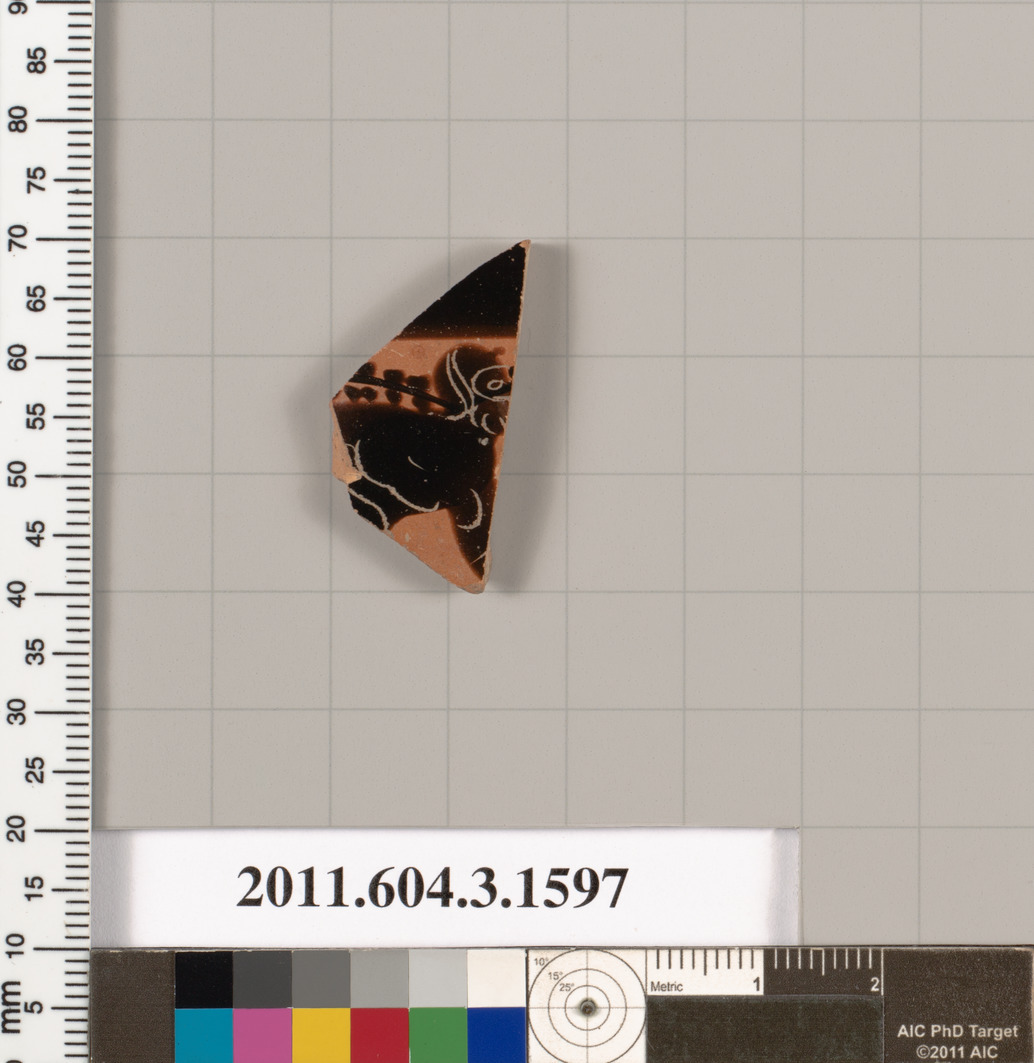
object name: kylix fragment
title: Terracotta fragment of a kylix: Band cup (drinking cup)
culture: greek, attic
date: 550-526 BCE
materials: terracotta